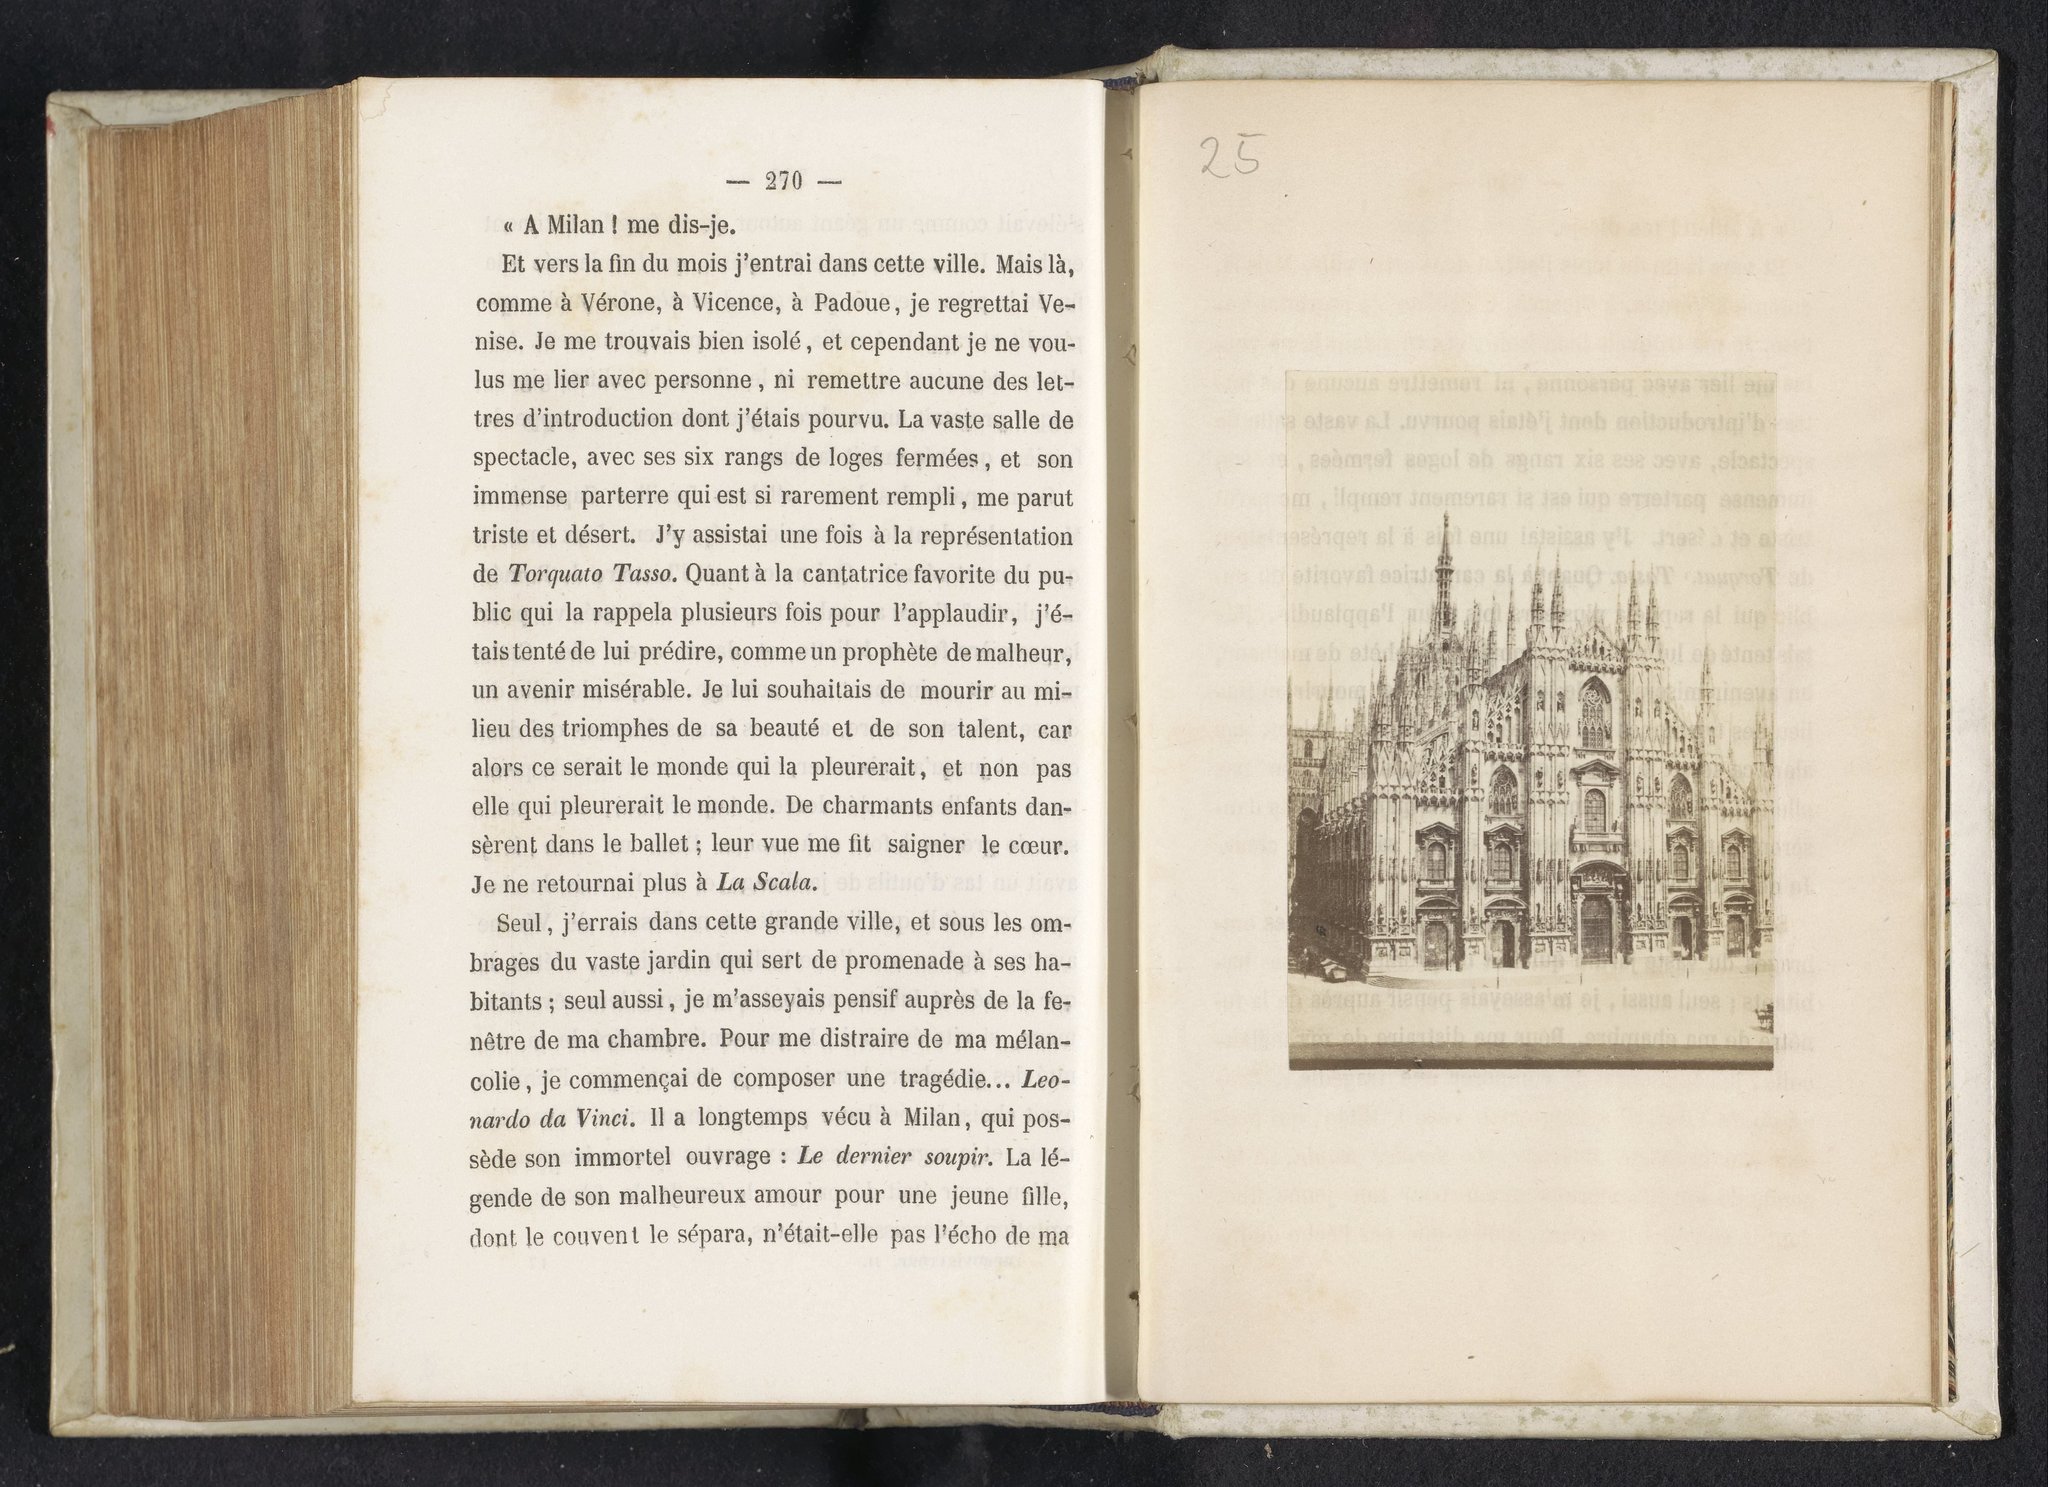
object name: photograph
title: Fotoreproductie van een tekening, voorstellende de voorgevel van de Dom van Milaan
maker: Anonymous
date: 1850-1860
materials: photographic support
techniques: albumen print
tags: theatre (building), façade (of house or building)